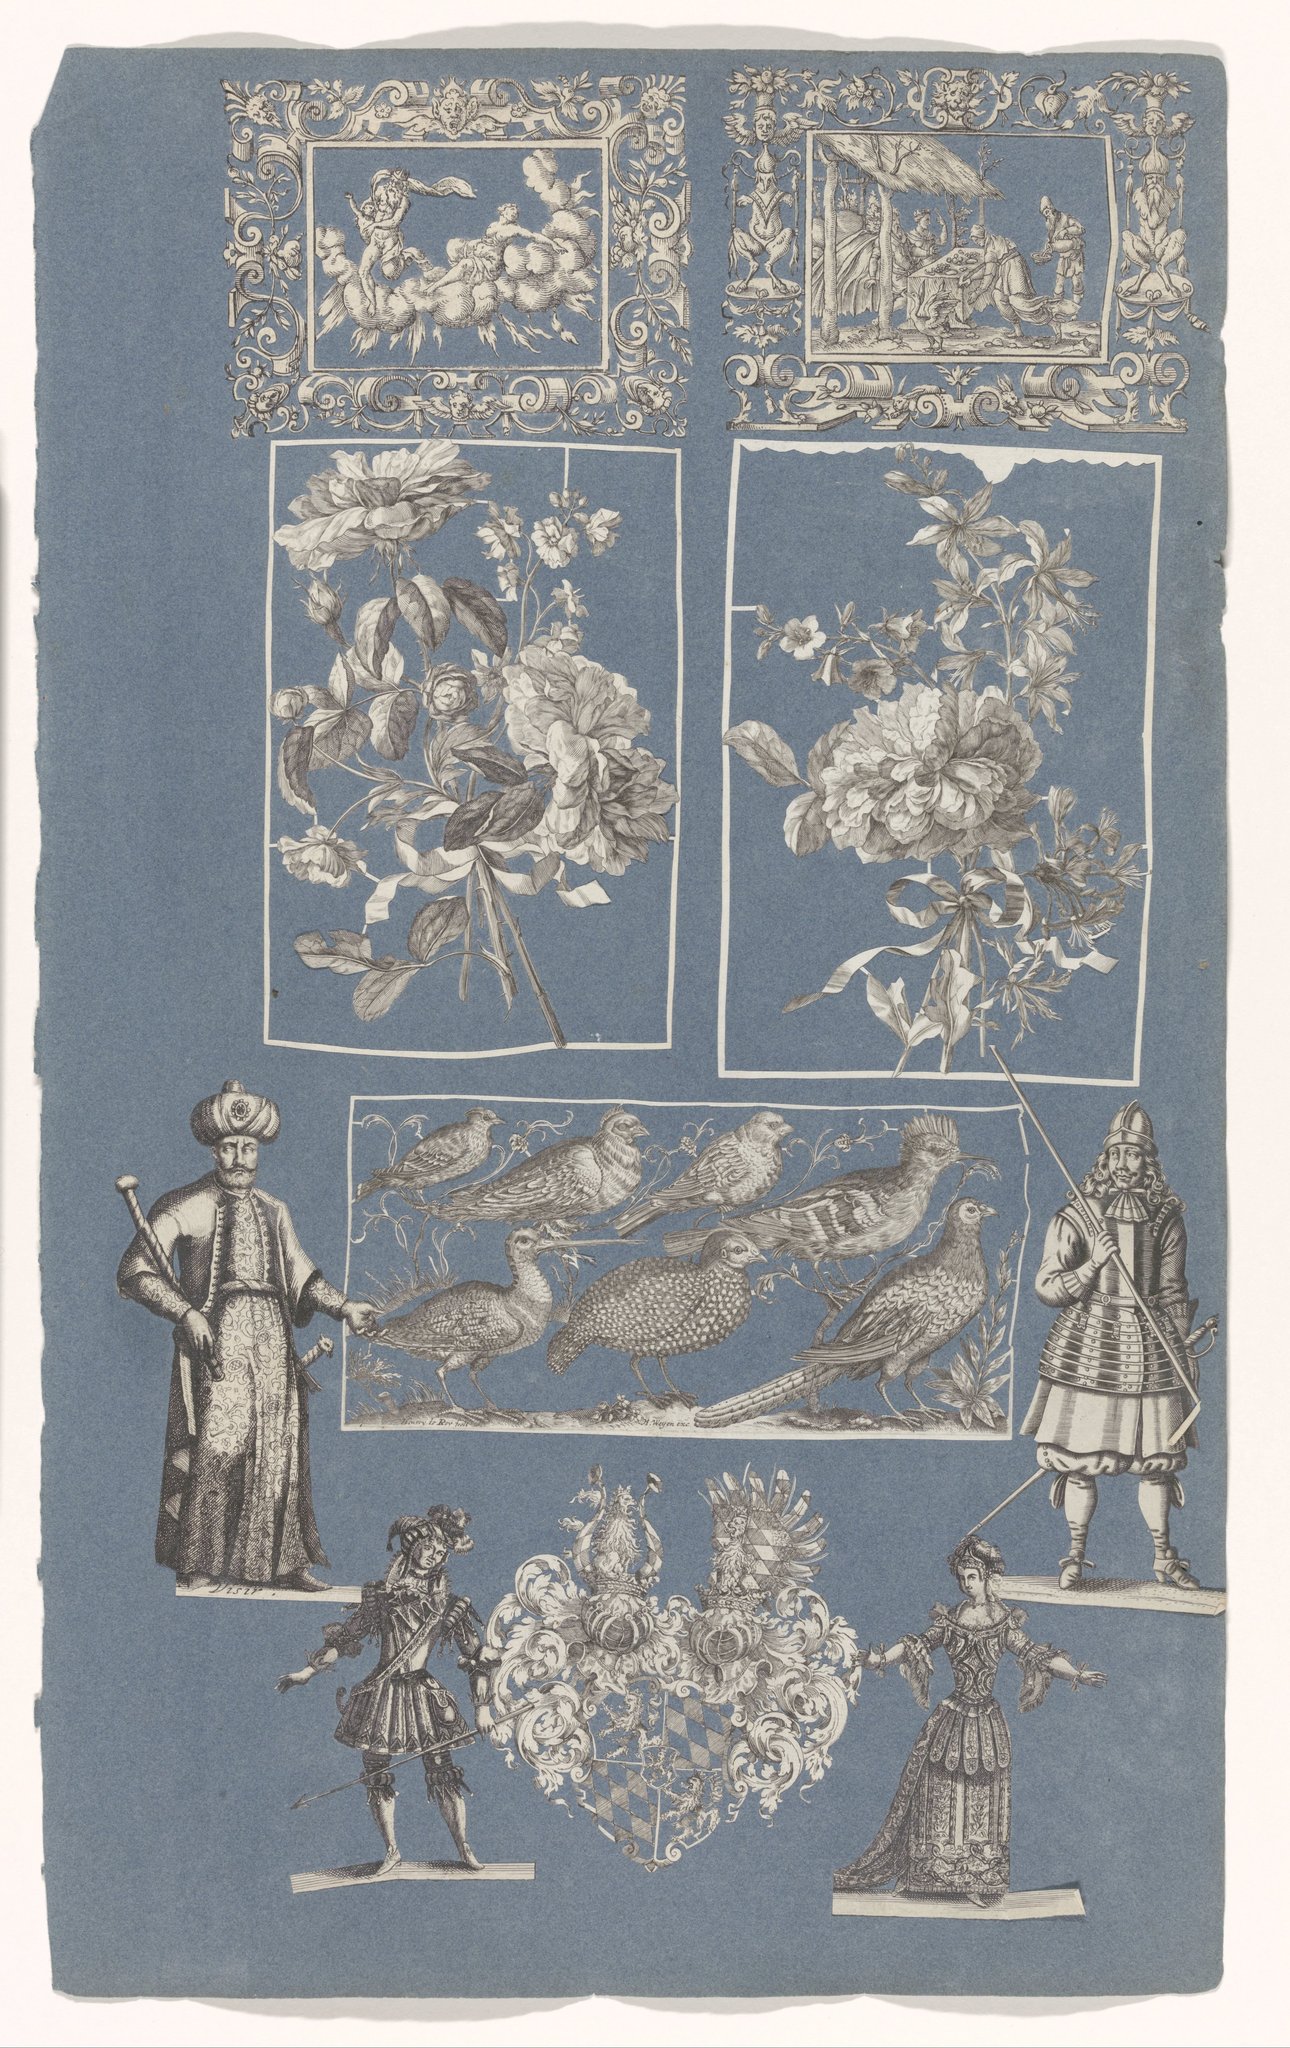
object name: collage visual work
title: Collage van uitgeknipte prenten geplakt op albumblad van blauw papier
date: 1585-1700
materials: paper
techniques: collage